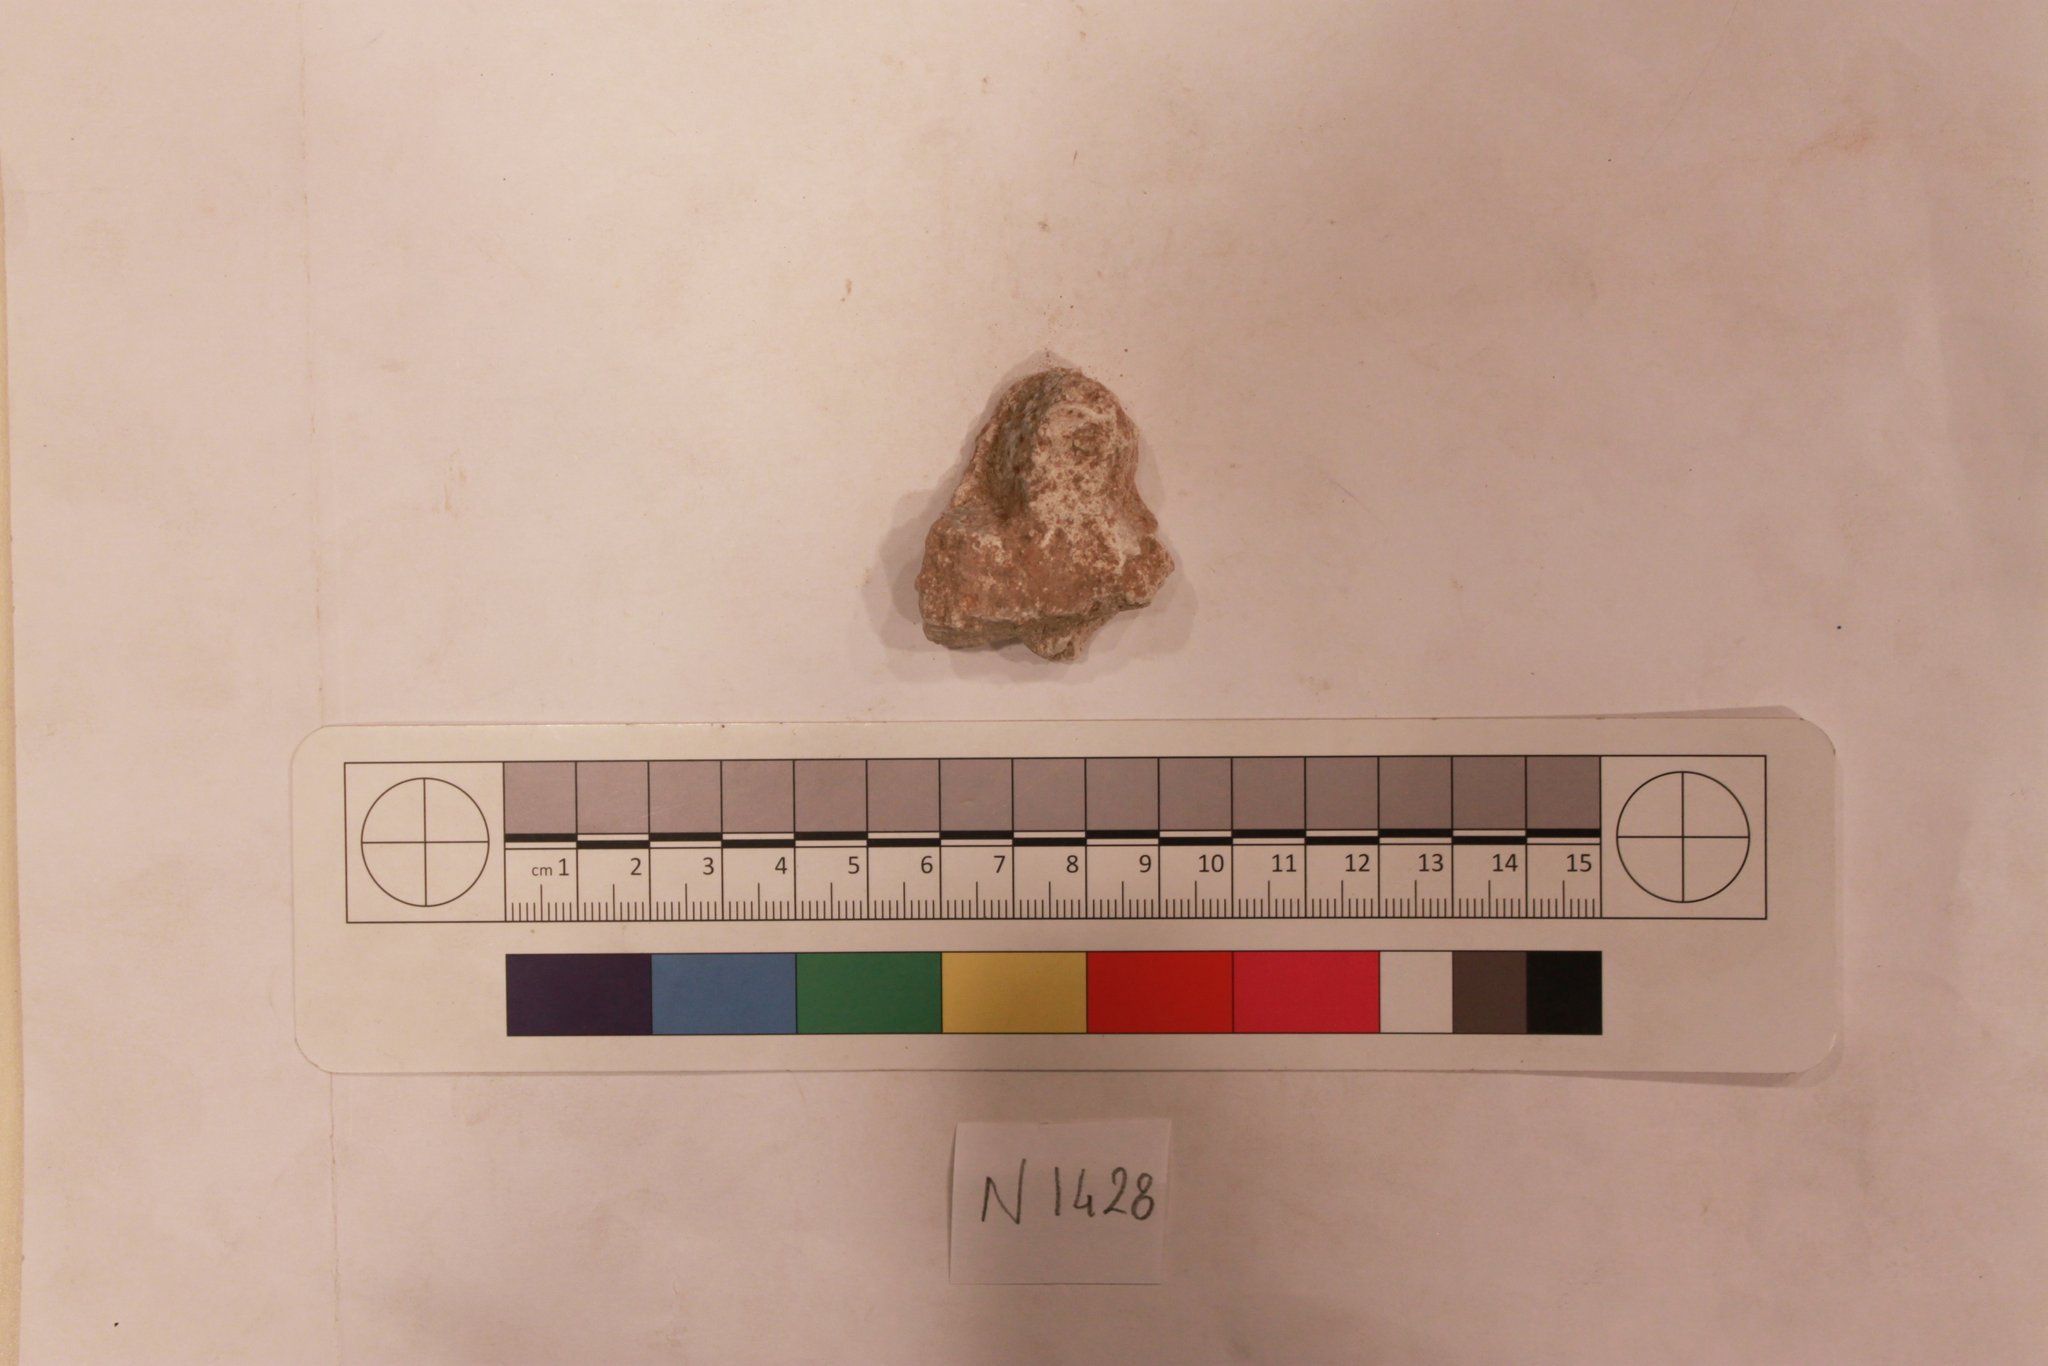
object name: fragment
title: Stucco Fragment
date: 701-1200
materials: plaster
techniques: carving, painting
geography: iran